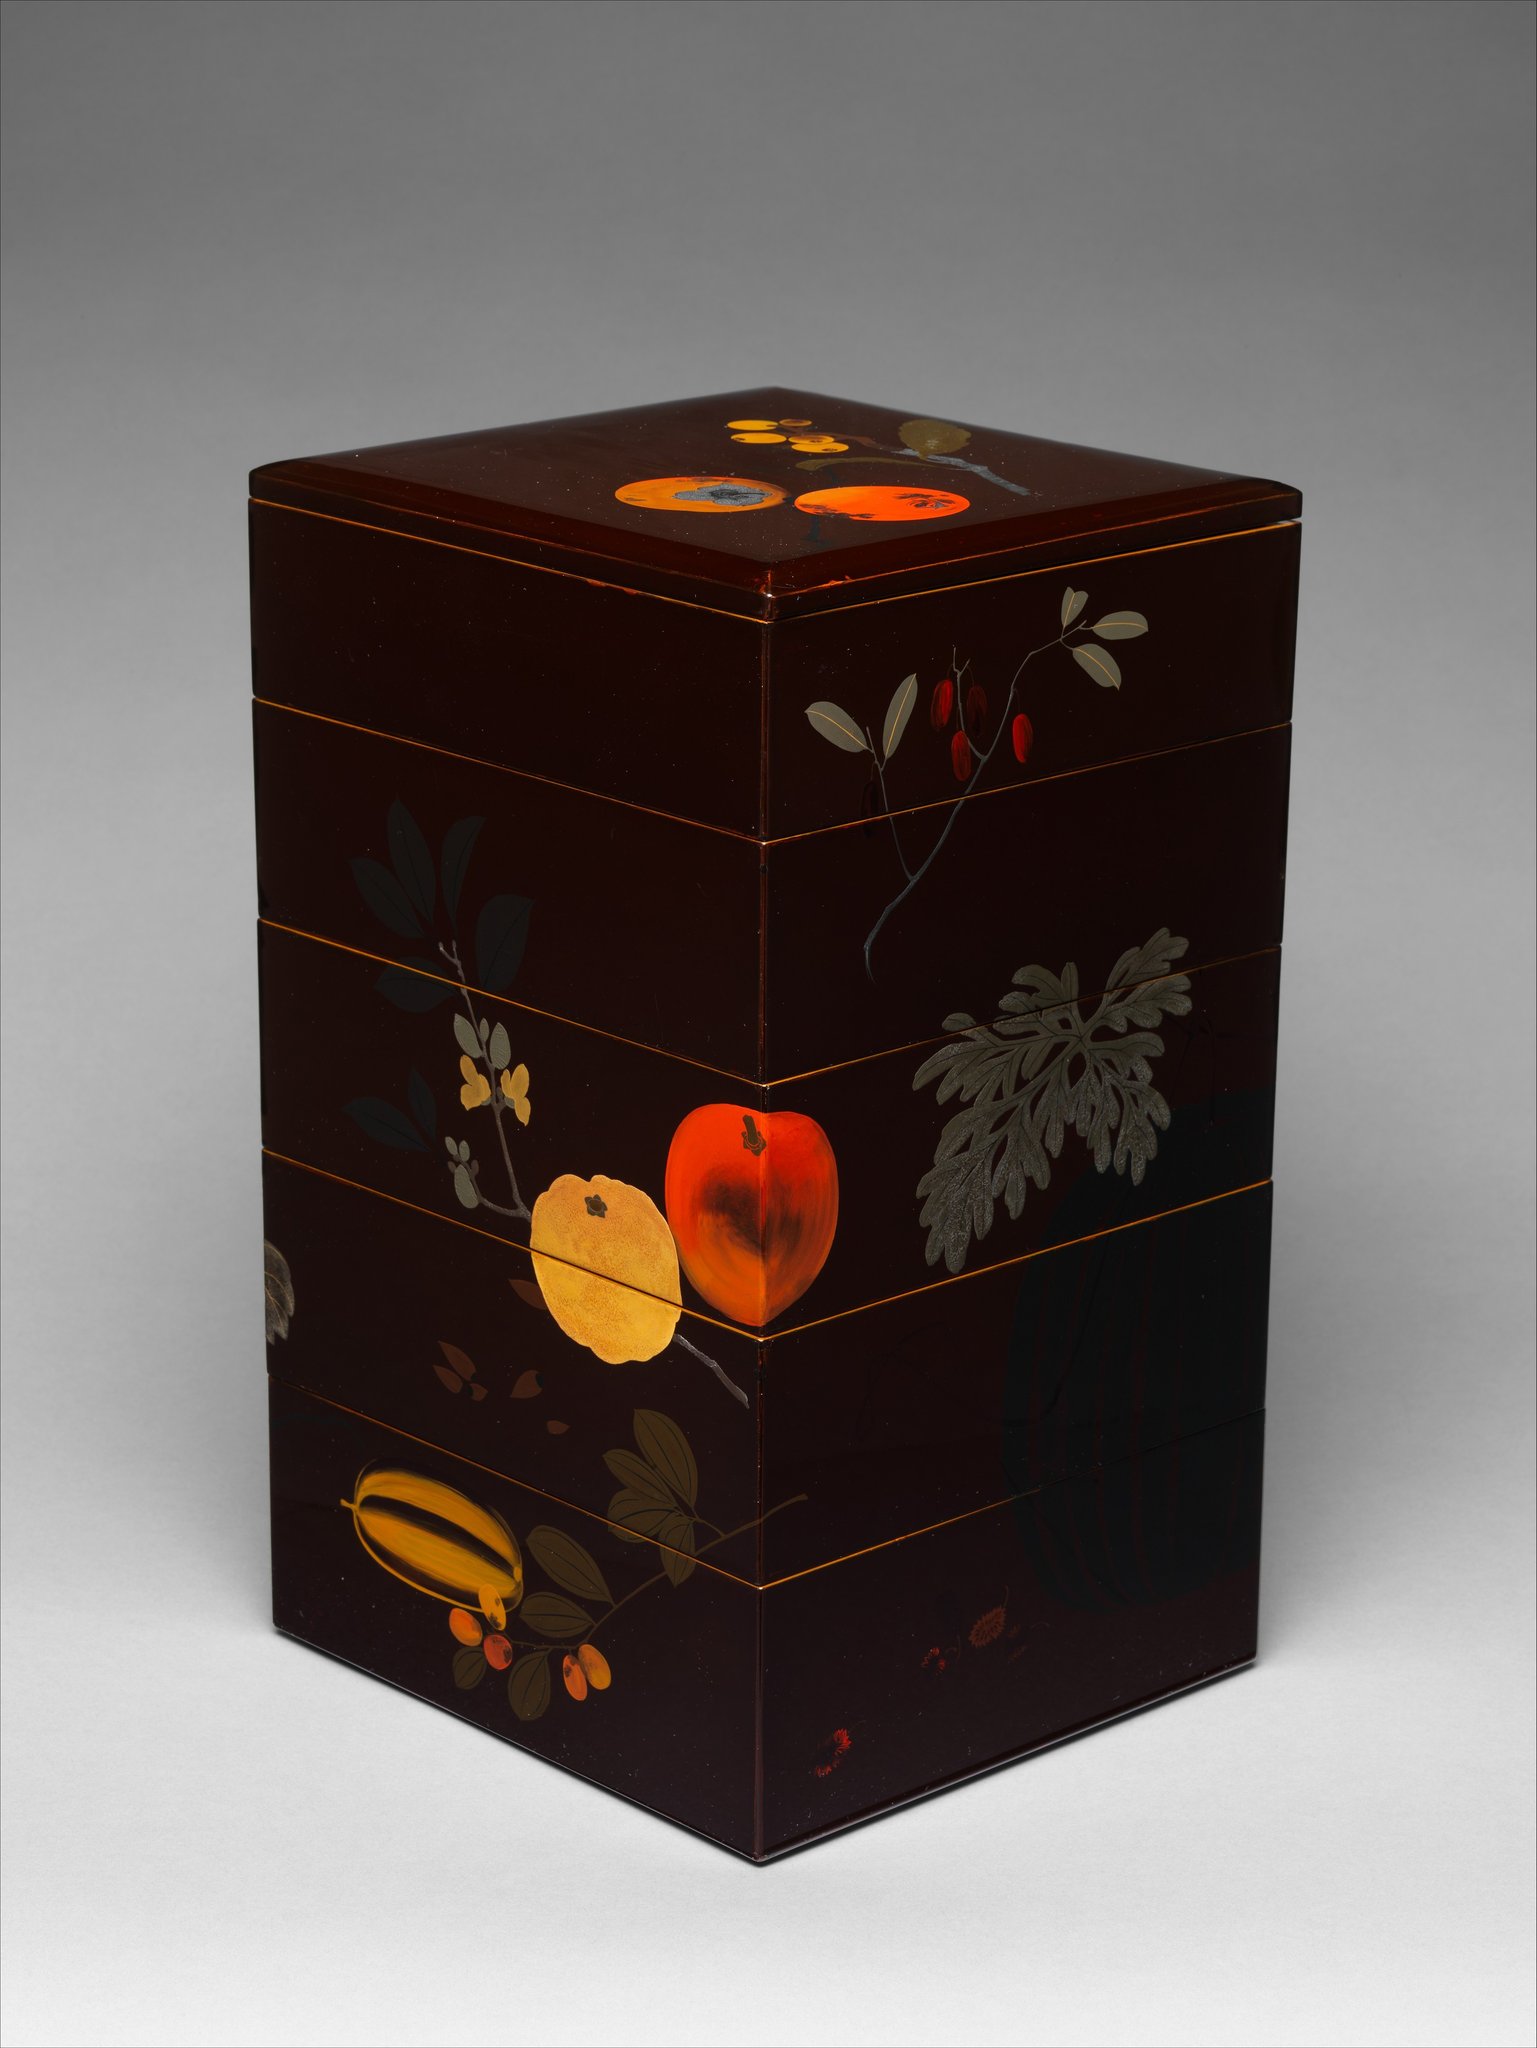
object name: tiered box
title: Tiered Food Box with Summer and Autumn Fruits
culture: japanese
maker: shibata zeshin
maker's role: artist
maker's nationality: japanese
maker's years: 1807-1891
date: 1868-1890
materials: gold, lacquer, silver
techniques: maki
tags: fruit